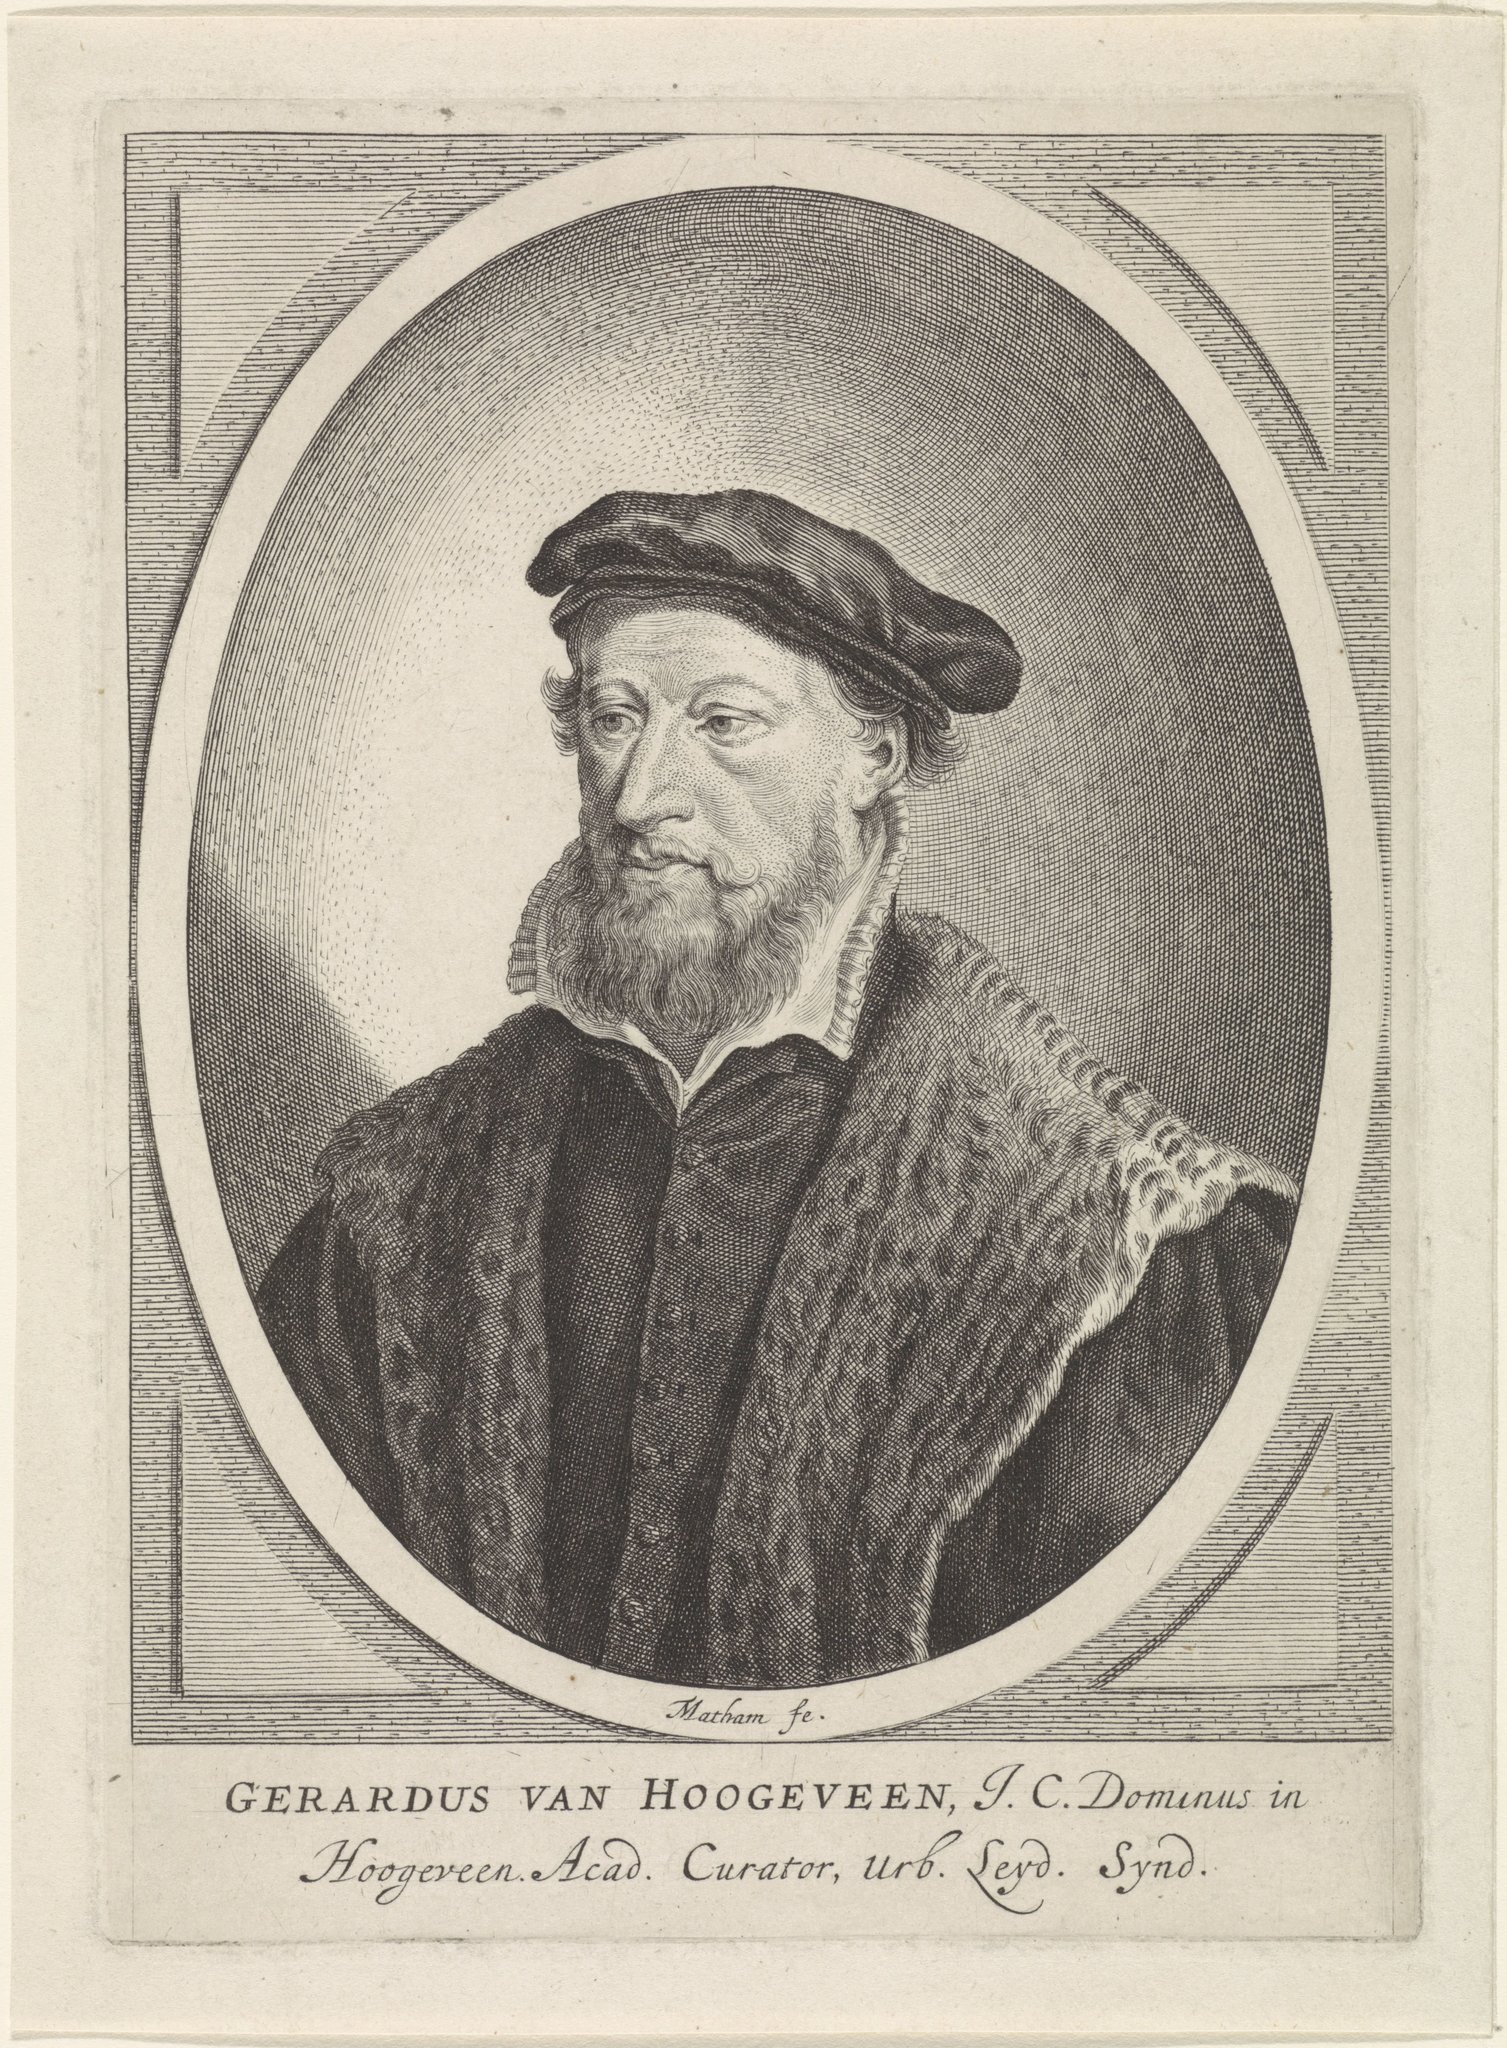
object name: print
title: Portret van Gerardus Amelisz. van Hoogeveen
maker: theodor matham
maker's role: draughtsman, print maker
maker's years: 1605-1676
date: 1623-1676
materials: paper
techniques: engraving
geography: northern netherlands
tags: gerardus amelisz. van hoogeveen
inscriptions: collector's mark: Lugt 240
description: Portret van Gerardus Amelisz. van Hoogeveen, curator en pensionaris van Leiden.